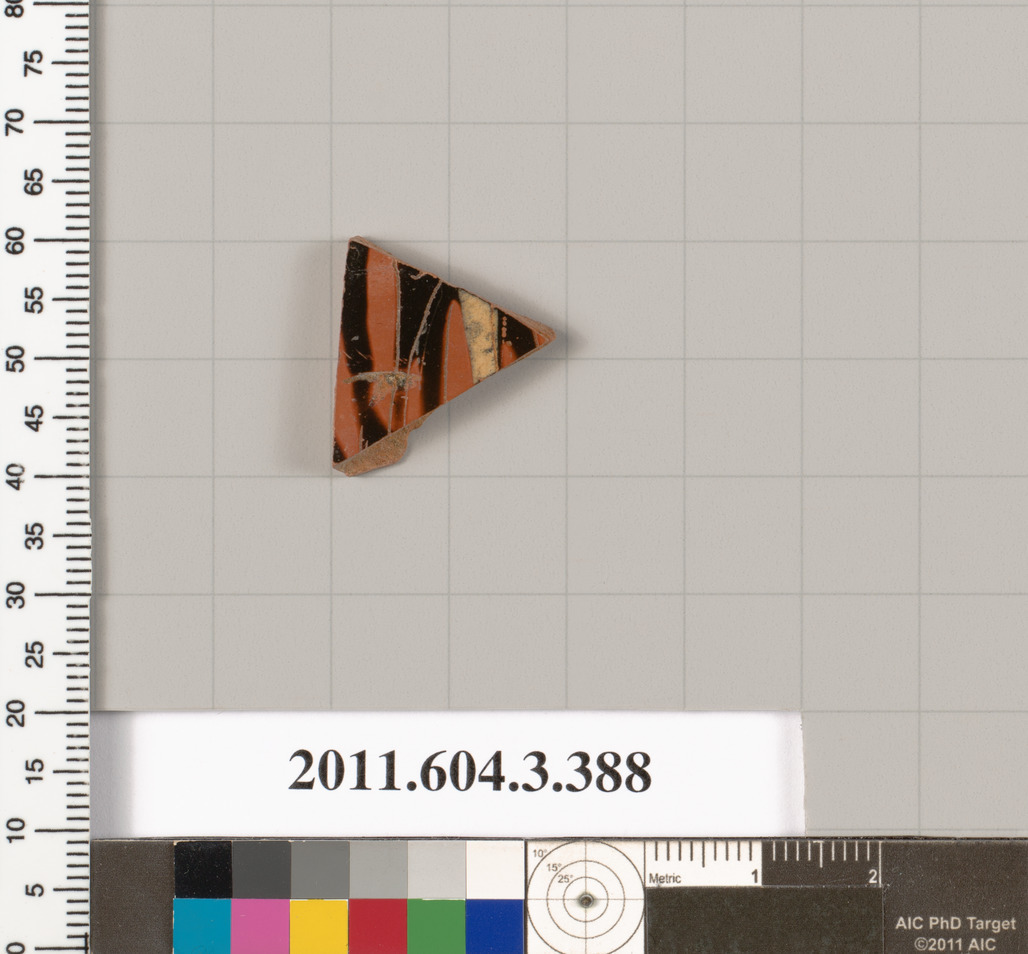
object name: neck amphora fragment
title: Terracotta fragment of a neck-amphora (jar)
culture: greek, attic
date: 530-520 BCE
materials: terracotta